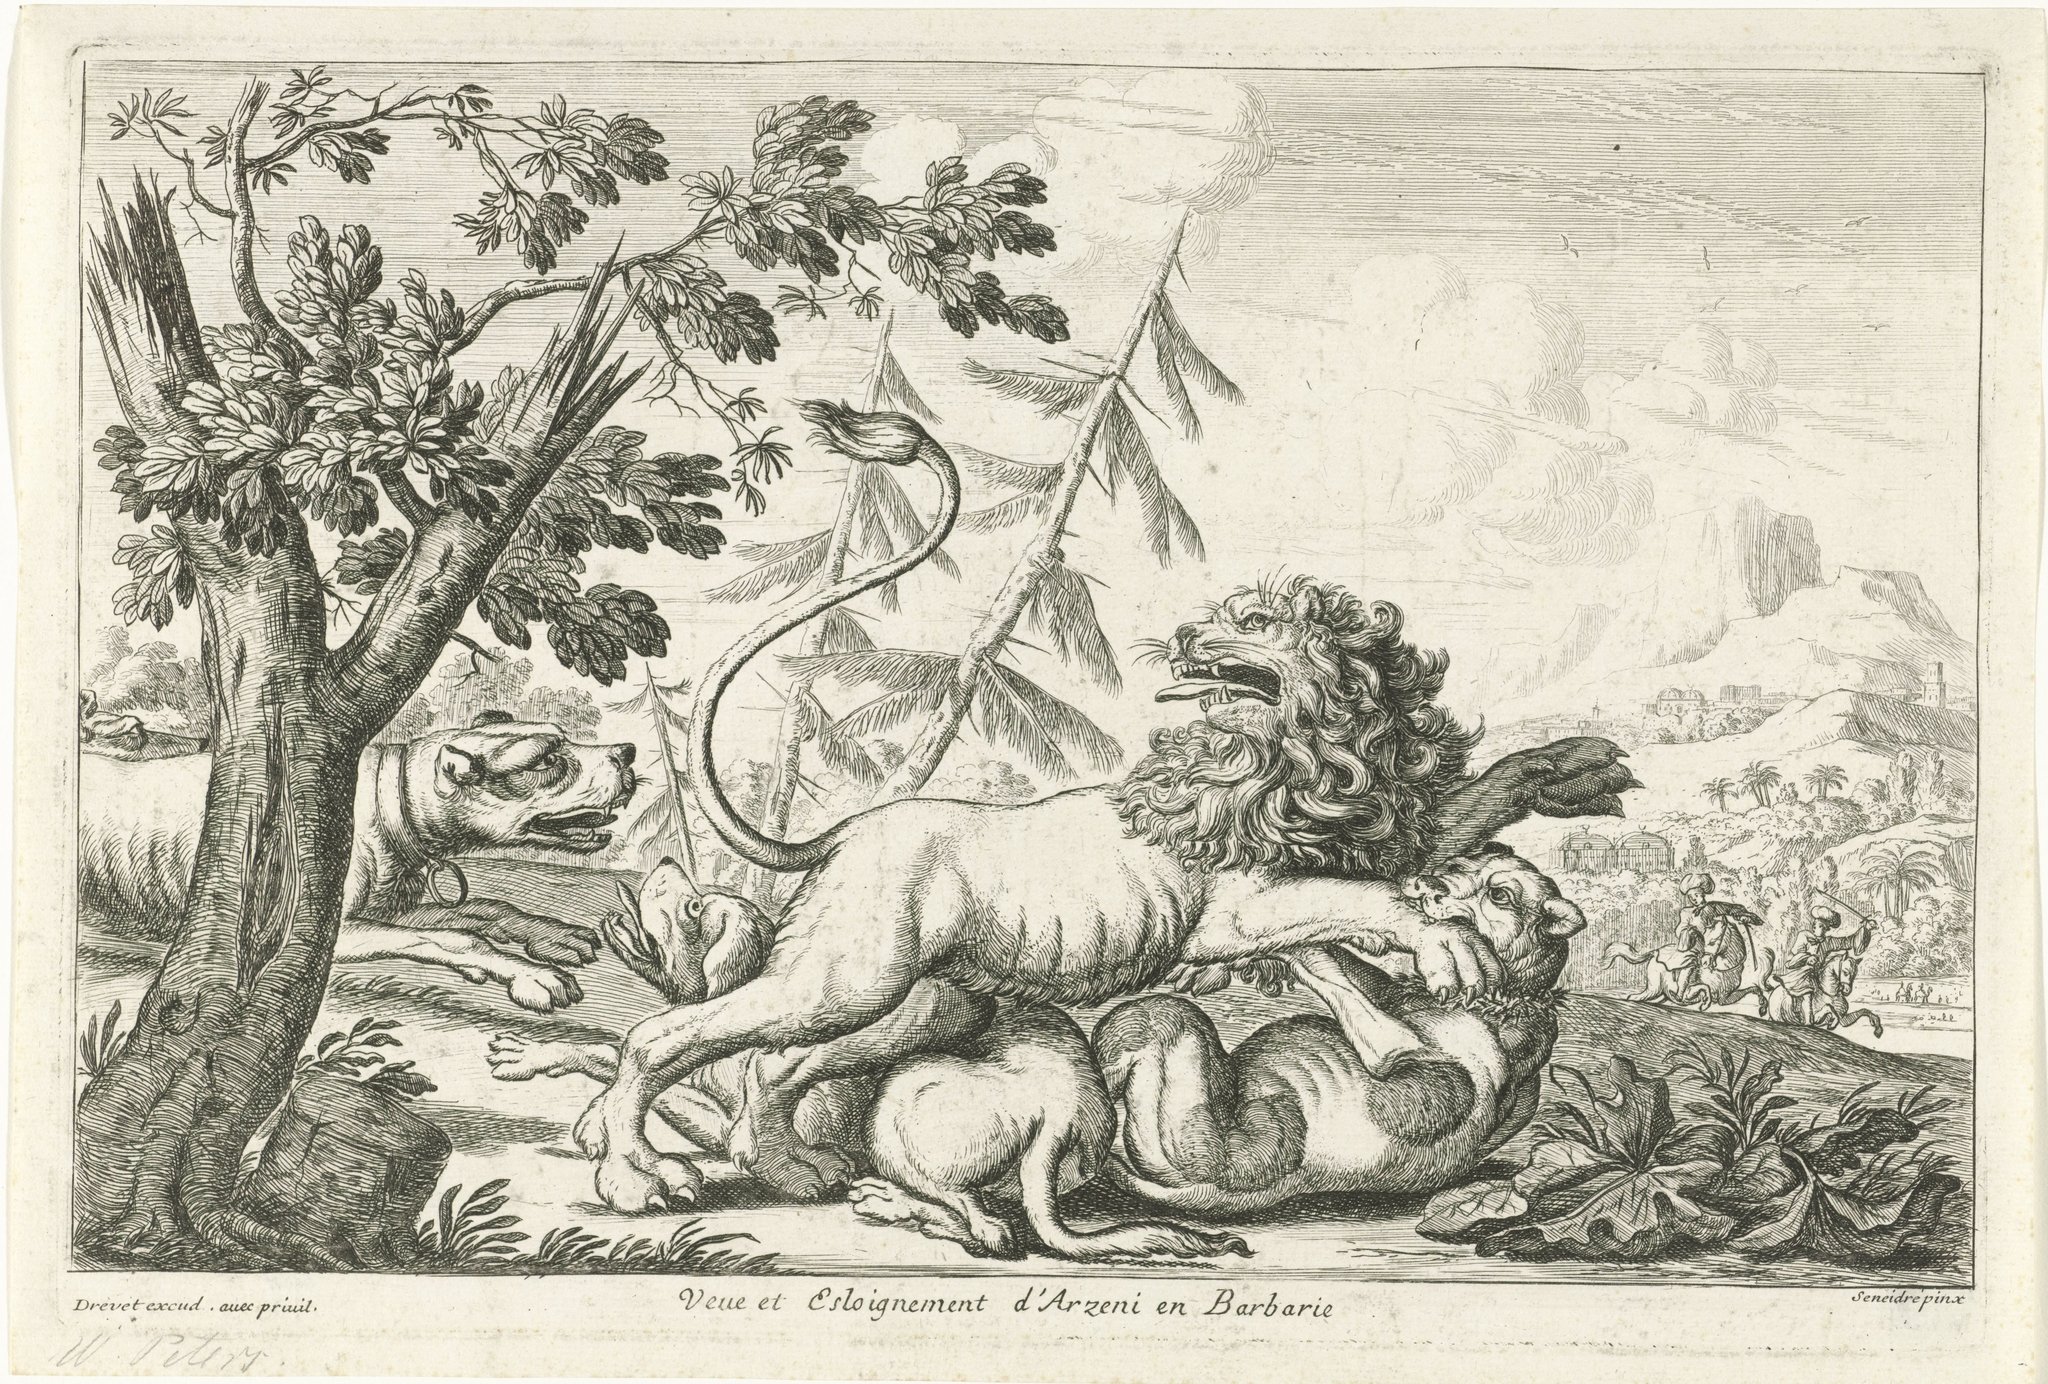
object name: print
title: Leeuwenjacht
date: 1622-1652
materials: paper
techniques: etching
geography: antwerp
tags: lion hunt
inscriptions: collector's mark: Lugt 2228, collector's mark: Lugt 2165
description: Landschap met een leeuwenjacht. Rechts op de achtergrond een gezicht op Arzeni (Arzeou), op het eiland Barbados. In de marge een onderschrift in het Frans.